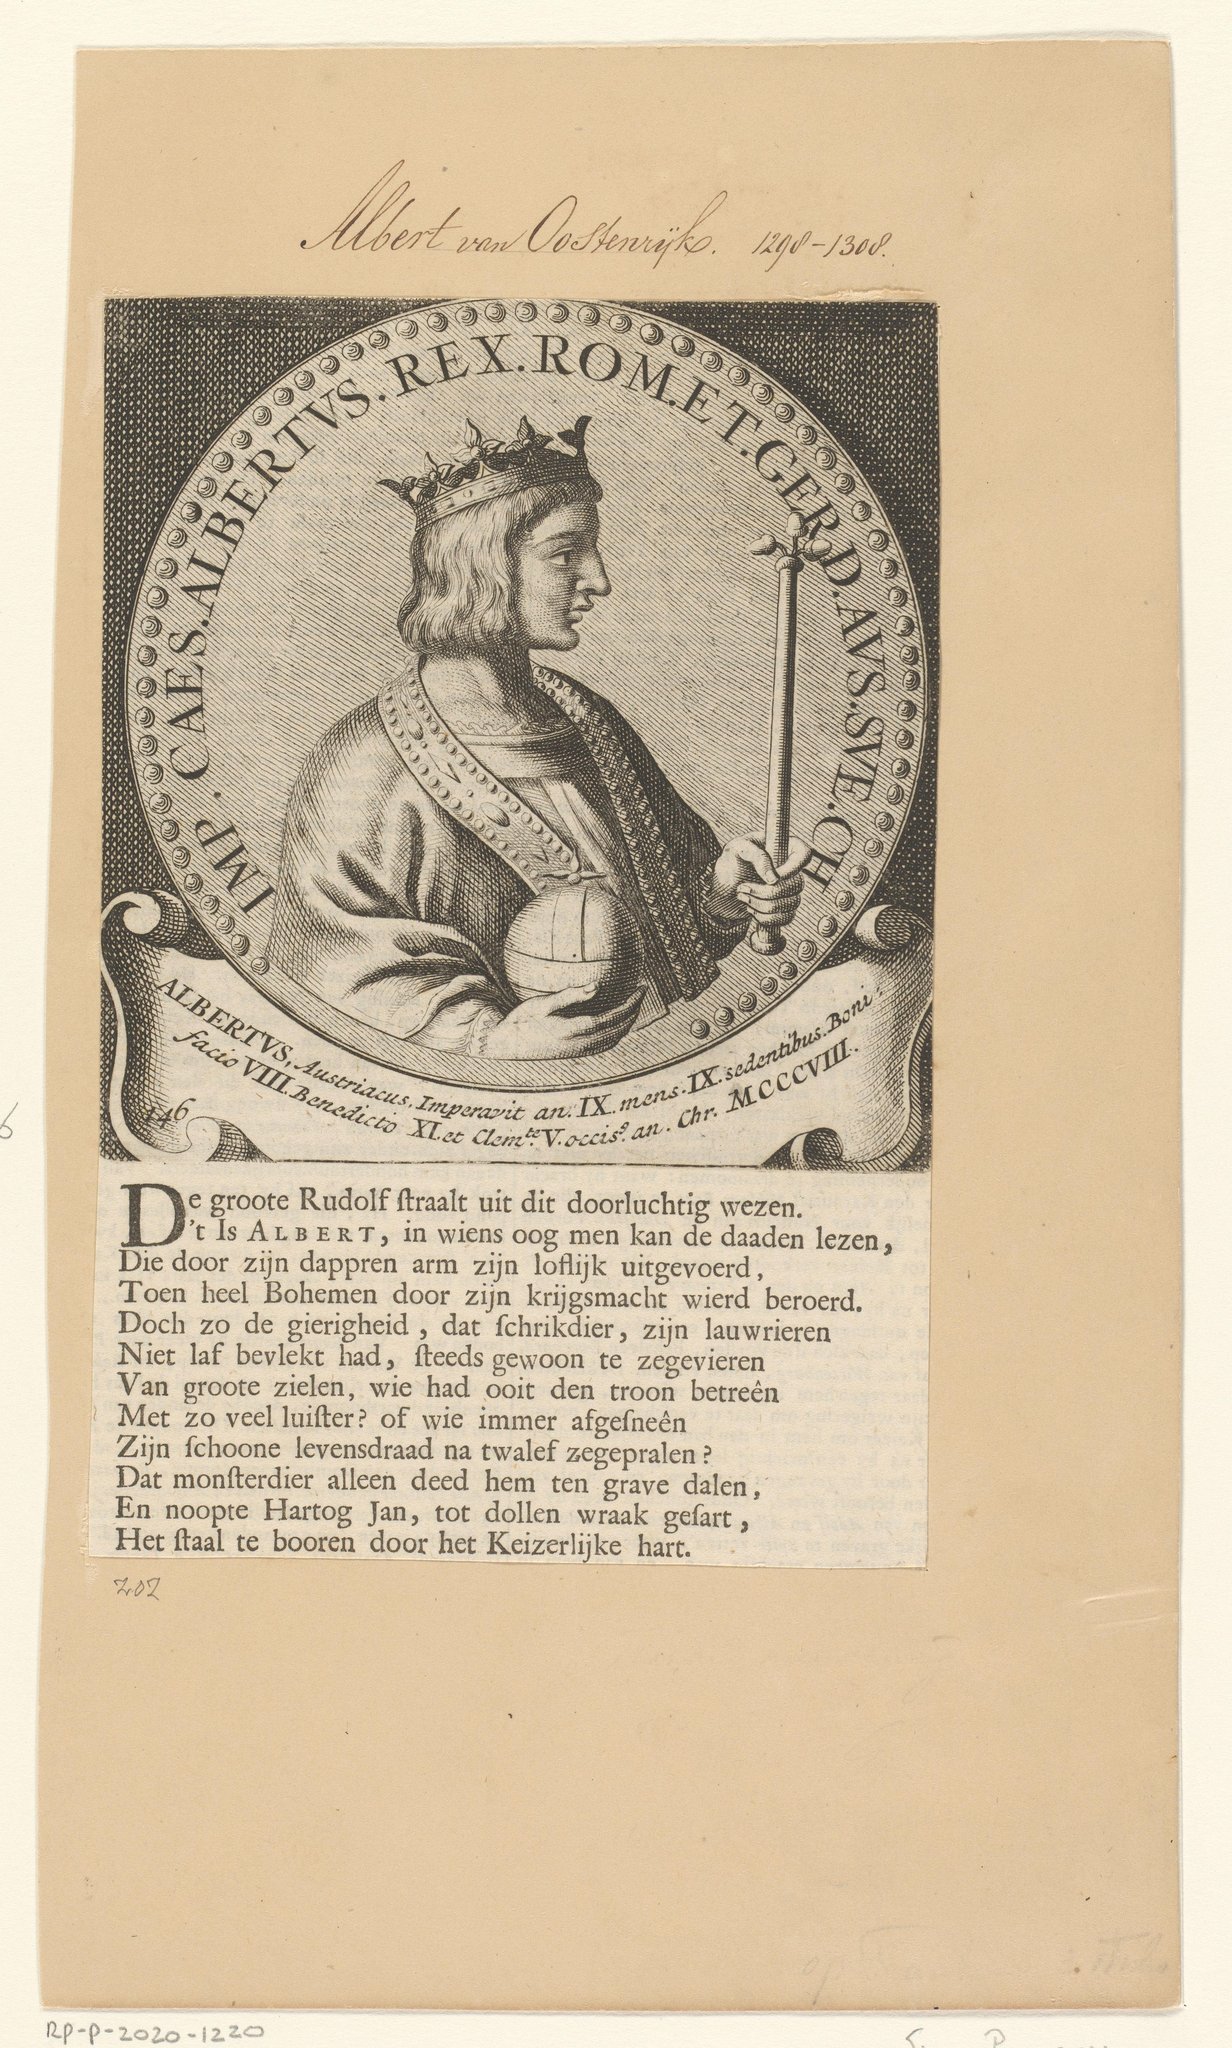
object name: print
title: Portret van Albrecht I van Habsburg, Rooms-Duits koning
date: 1697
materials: paper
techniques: engraving, etching, letterpress printing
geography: utrecht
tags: crown (symbol of sovereignty), sceptre, staff (symbol of sovereignty), historical persons, king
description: Prent uit: Bogaert, Abraham. De Roomsche monarchy, vertoont in de muntbeelden der westersche en oostersche keizeren (...). Utrecht: François Halma en Willem van de Water, 1697, p. 401. Eerste staat verschenen als grotere prent met 12 portretten, gedateerd 1695.